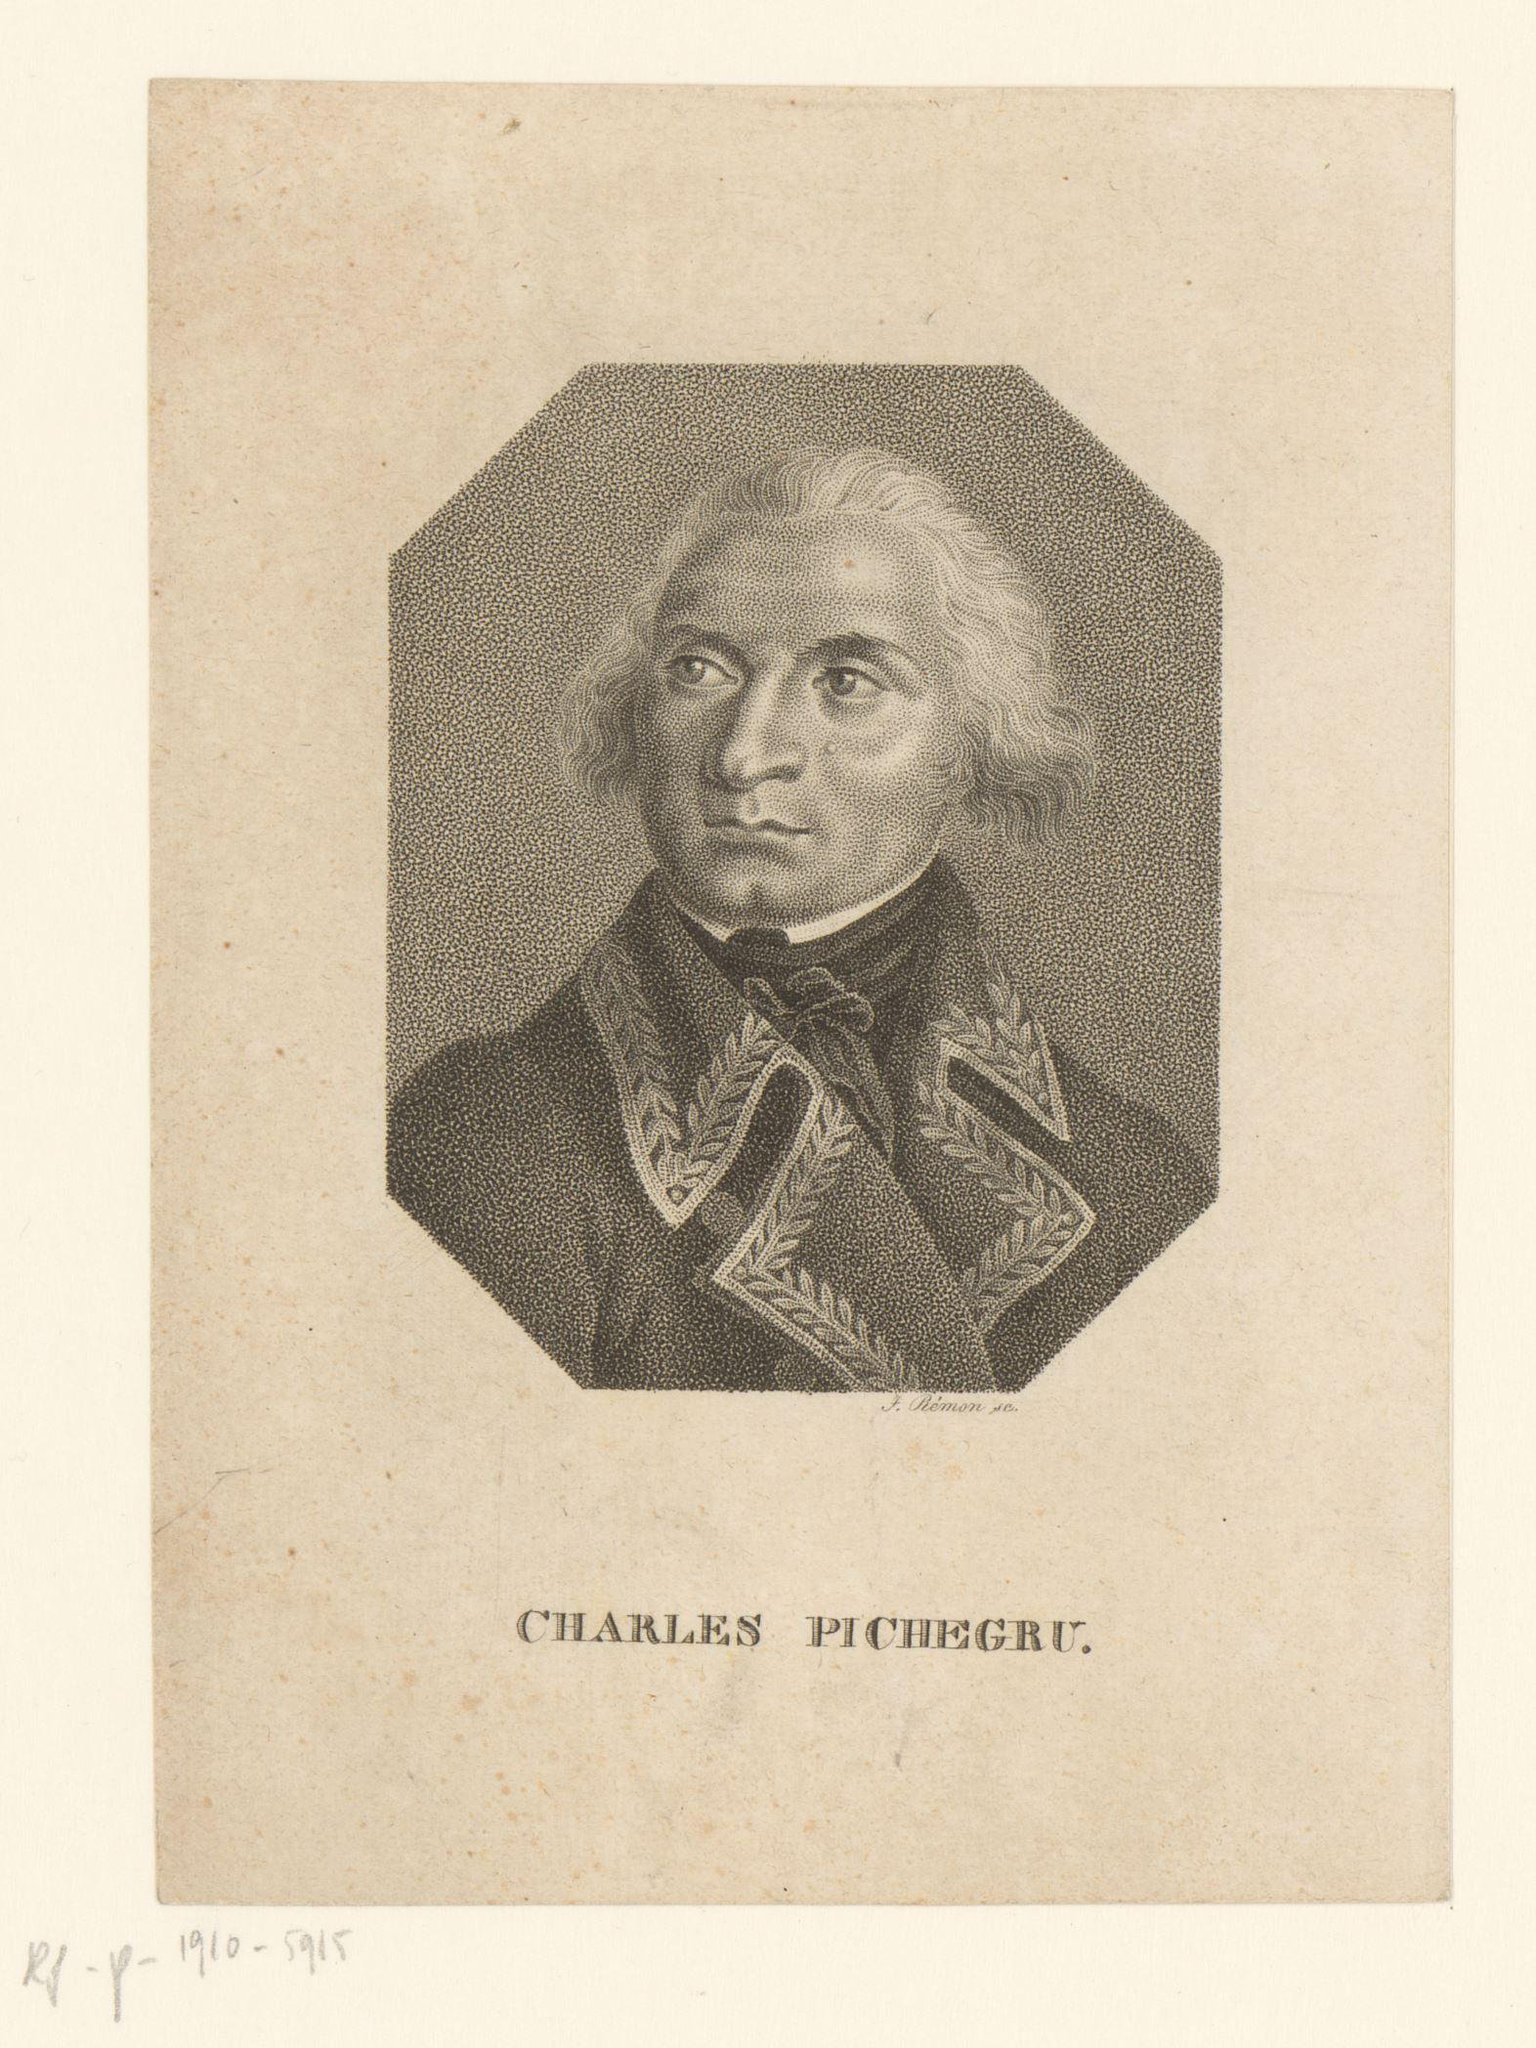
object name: print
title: Portret van Charles Pichegru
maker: j. rémon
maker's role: print maker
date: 1800-1899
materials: paper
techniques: stippling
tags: paris, jean-charles pichegru, historical persons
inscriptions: collector's mark: Lugt 2228